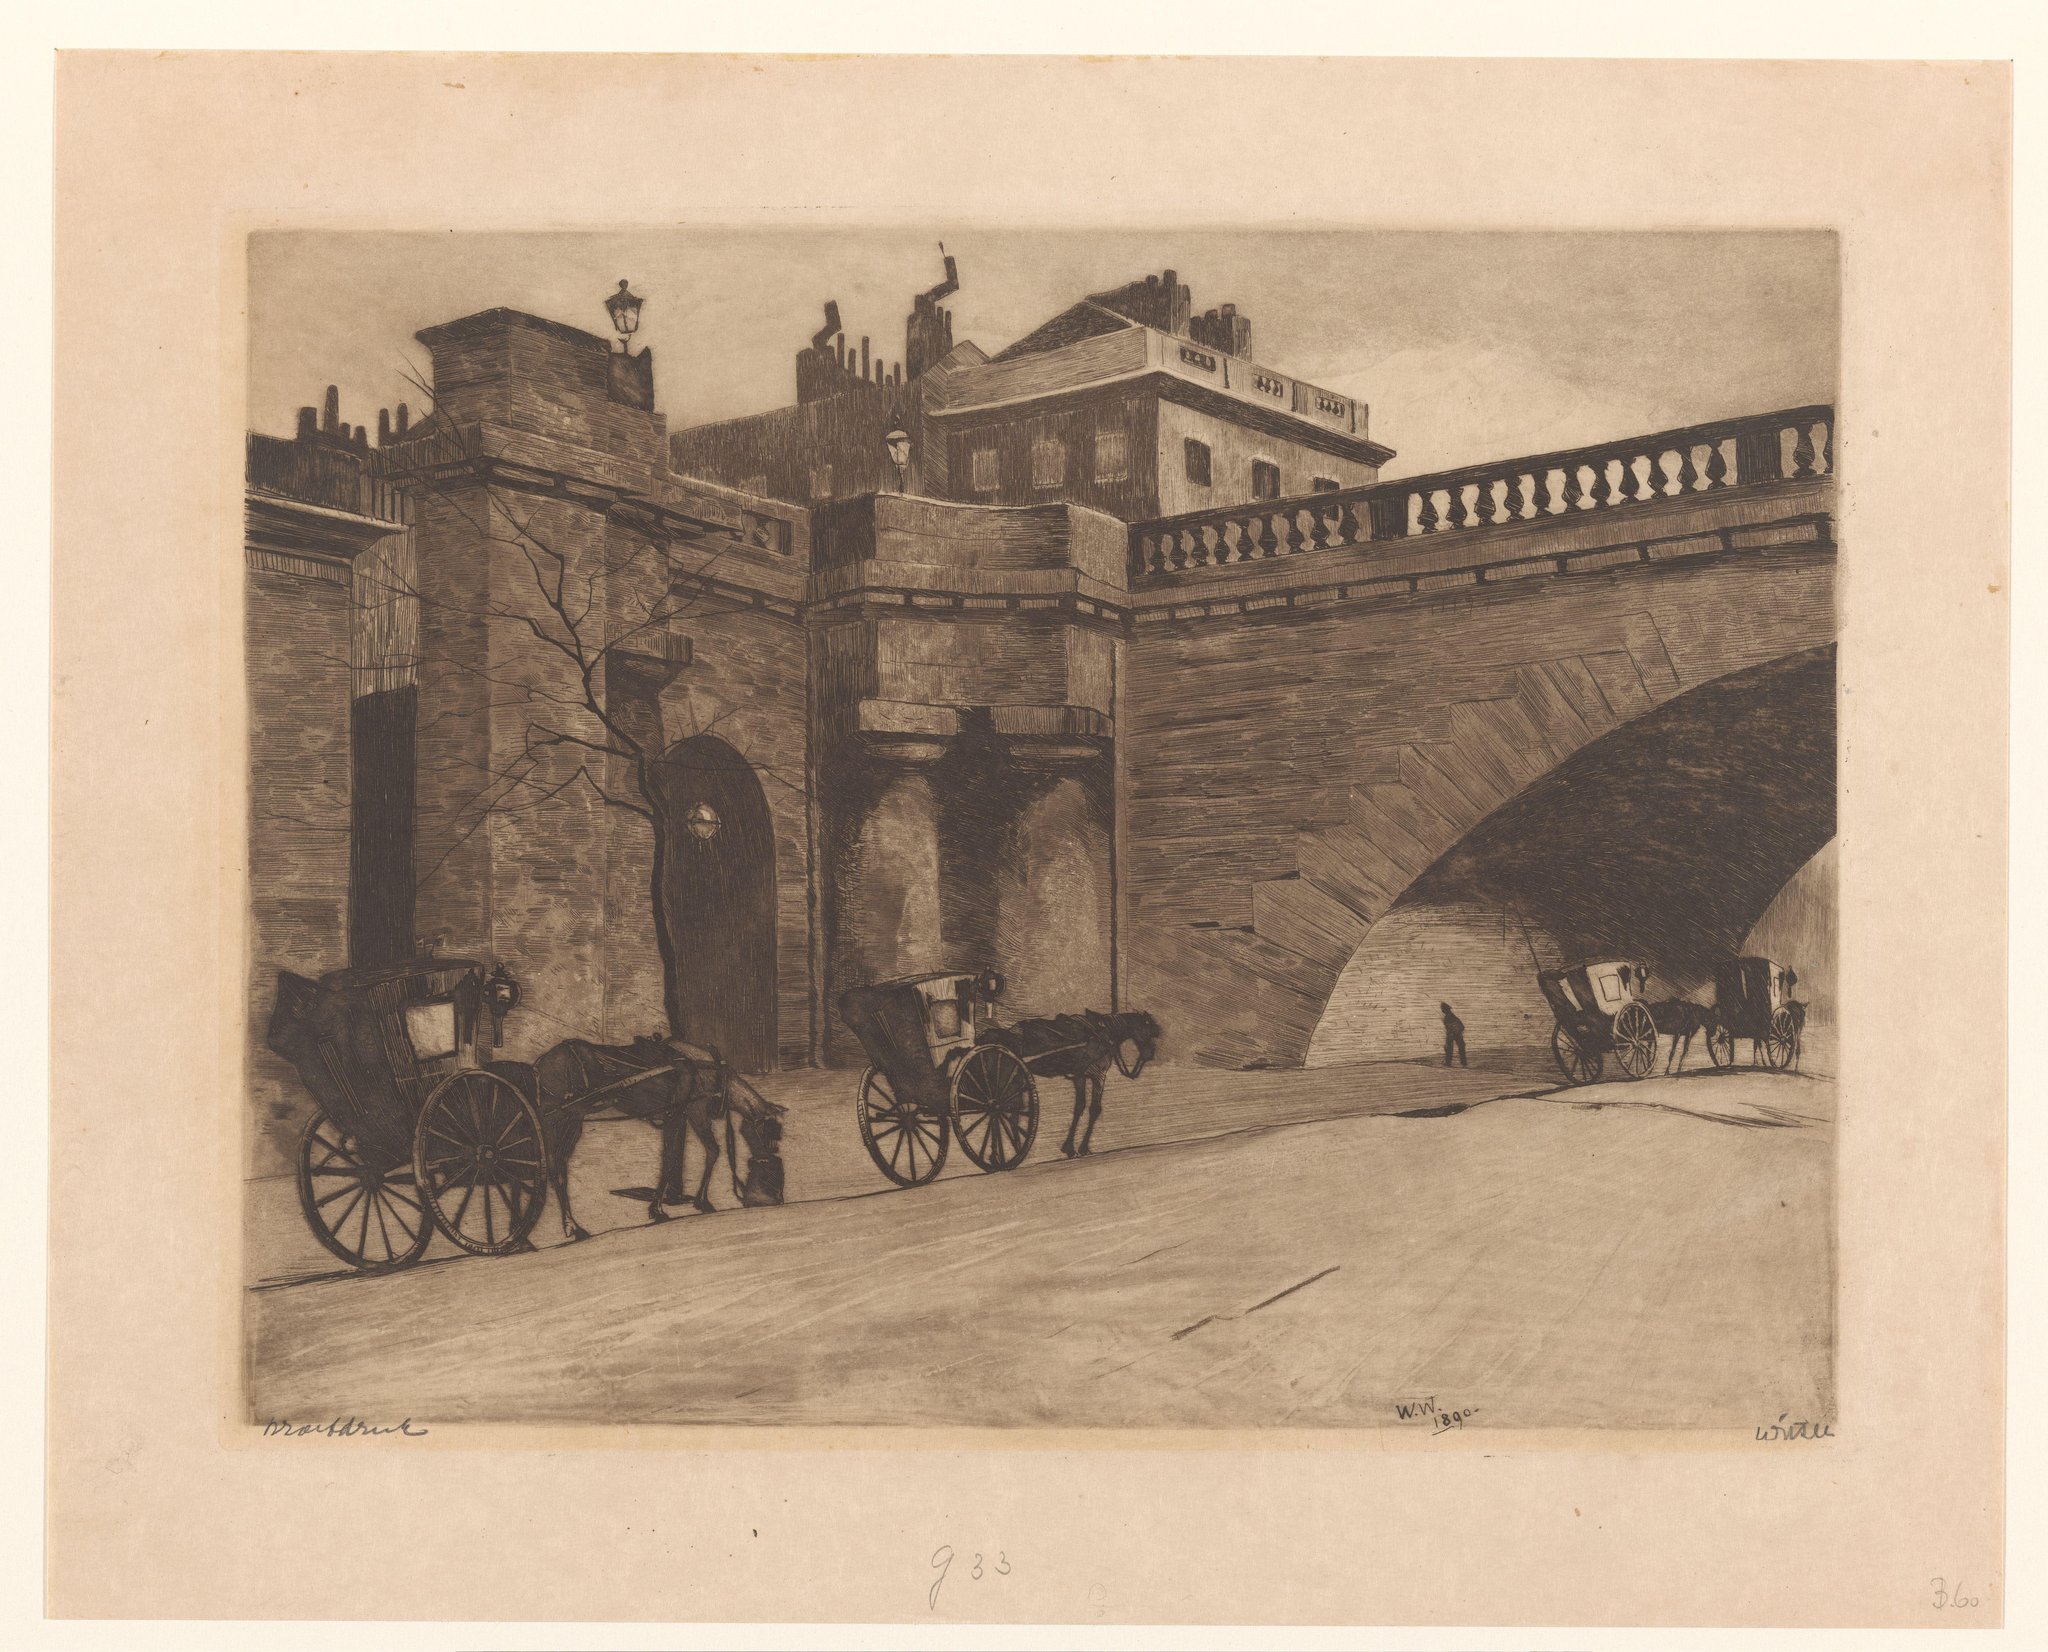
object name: print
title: Wachtende rijtuigen bij de Waterloo Bridge in Londen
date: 1890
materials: paper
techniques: aquatint, etching, intaglio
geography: london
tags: horse, bridge in city across river, canal, etc., passenger carriage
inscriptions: collector's mark: Lugt 2228, inscription: ‘proefdruk’, signature: ‘Witsen’